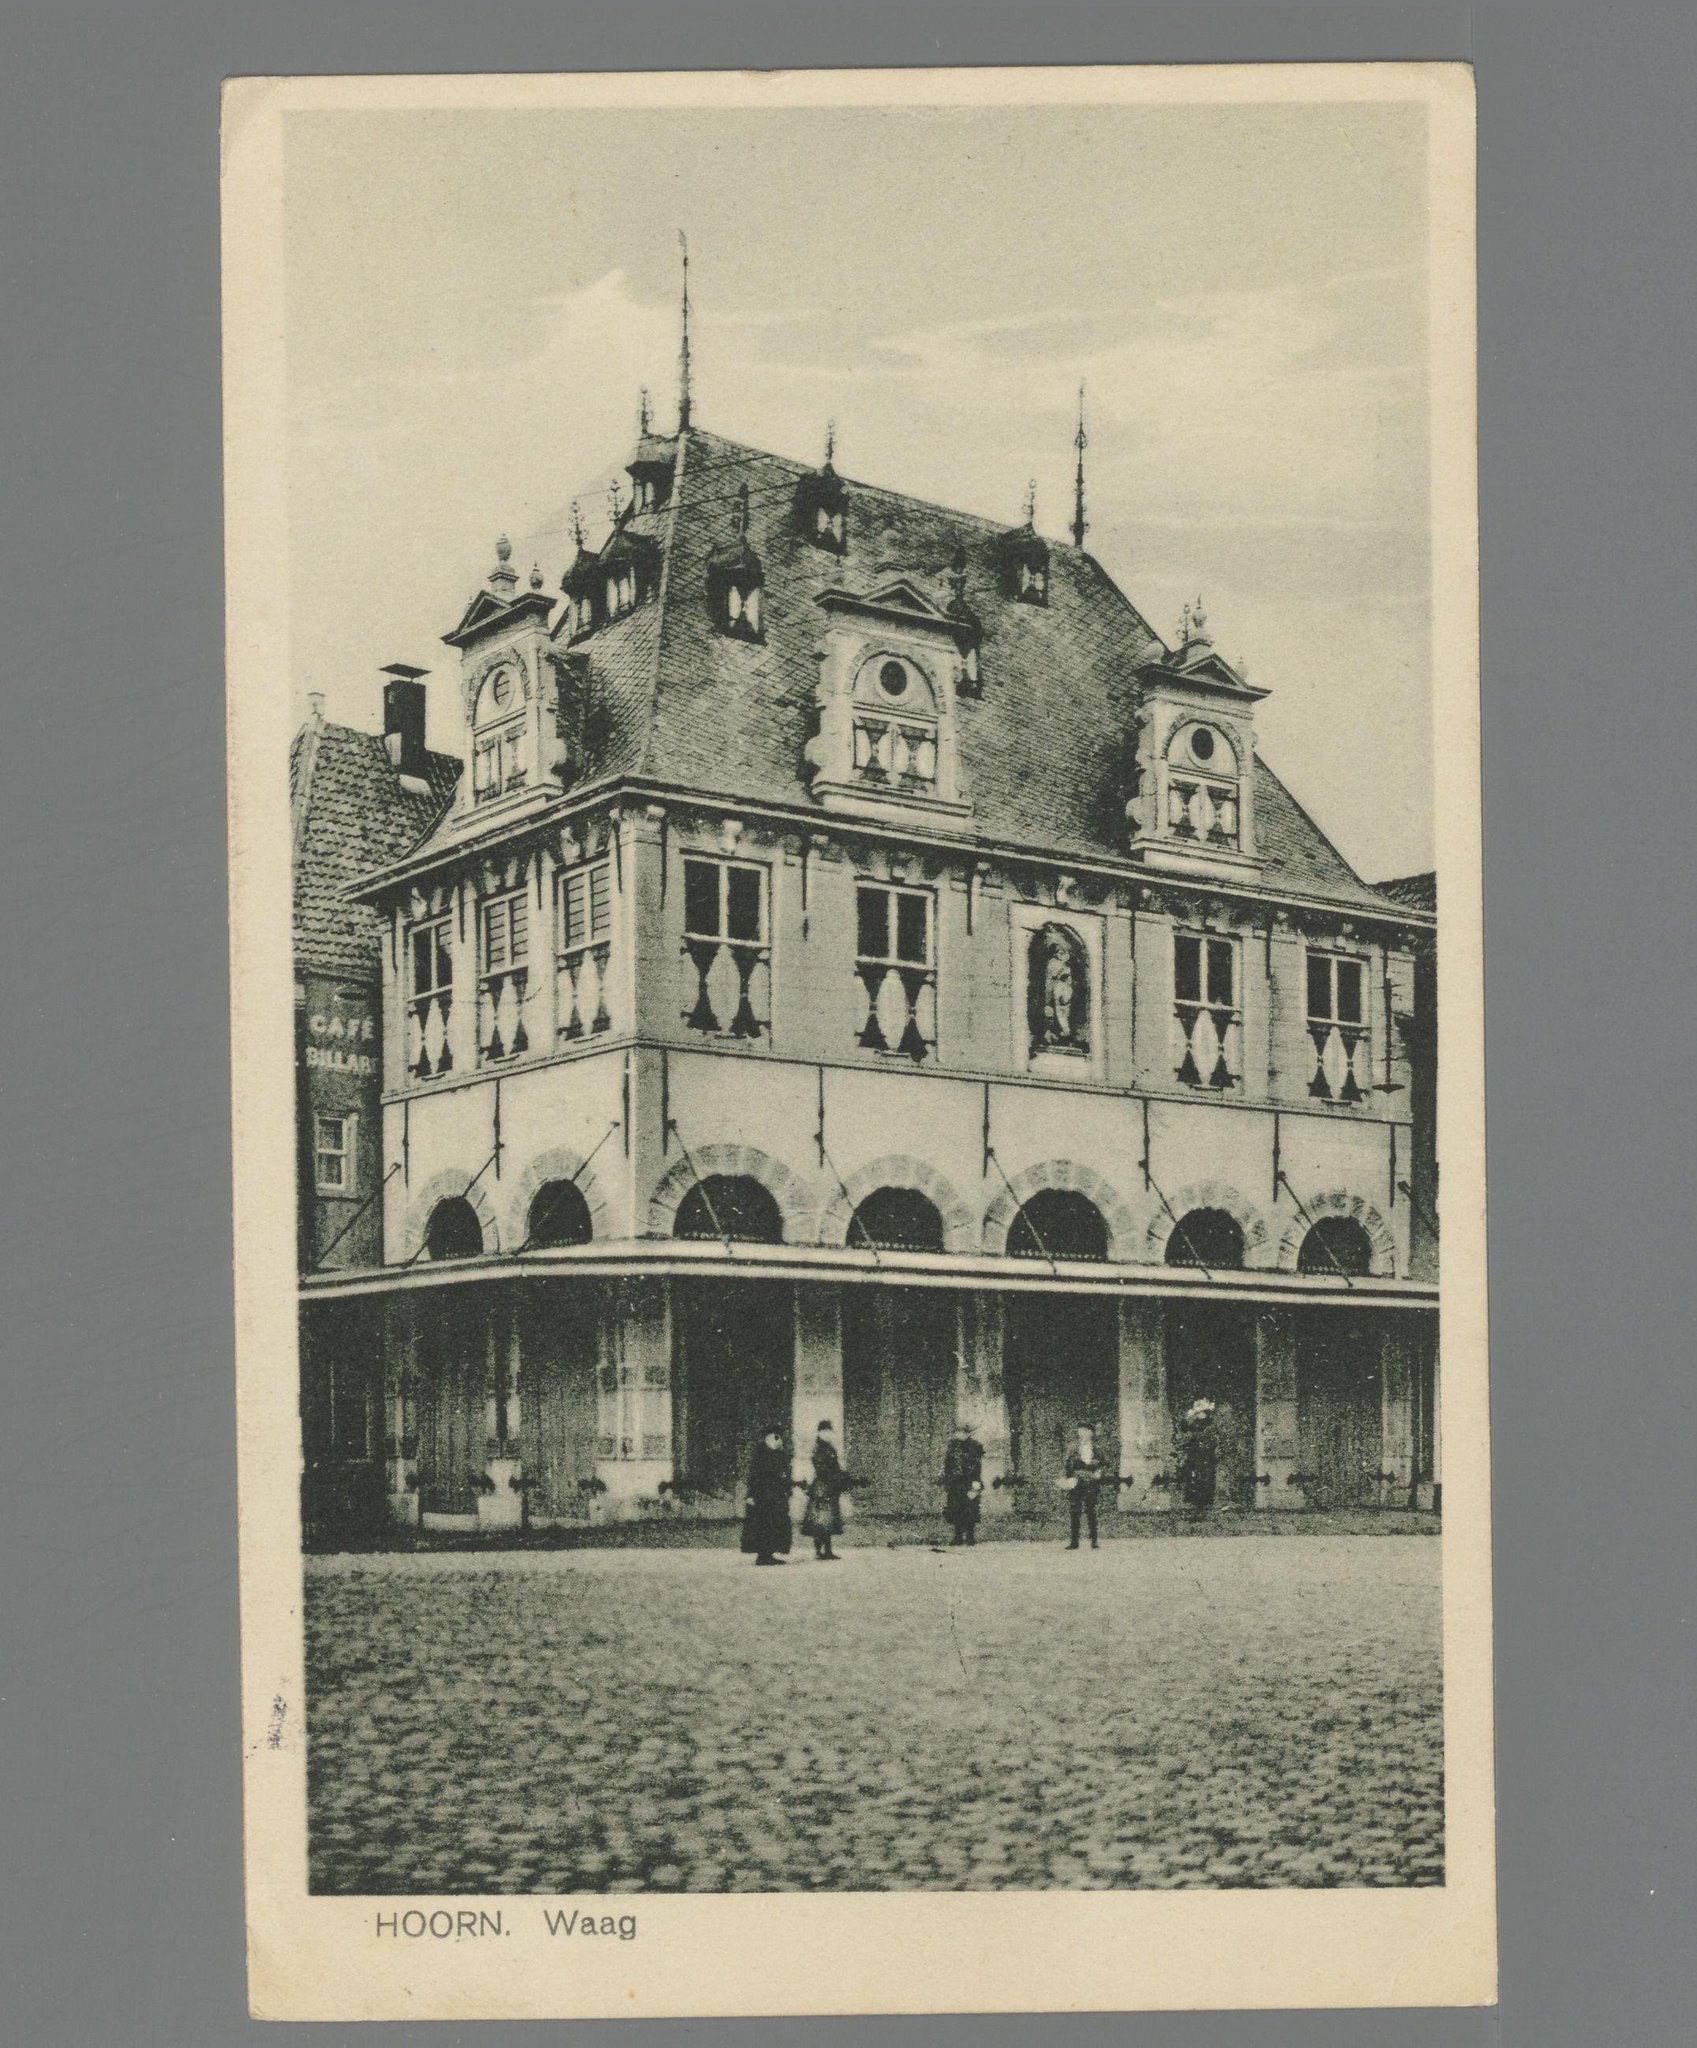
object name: ansichtkaart, prentbriefkaart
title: Hoorn. Waag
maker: Anonymous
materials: cardboard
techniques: photograph, writing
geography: utrecht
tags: weigh-house, hoorn (north holland)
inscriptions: postage stamp